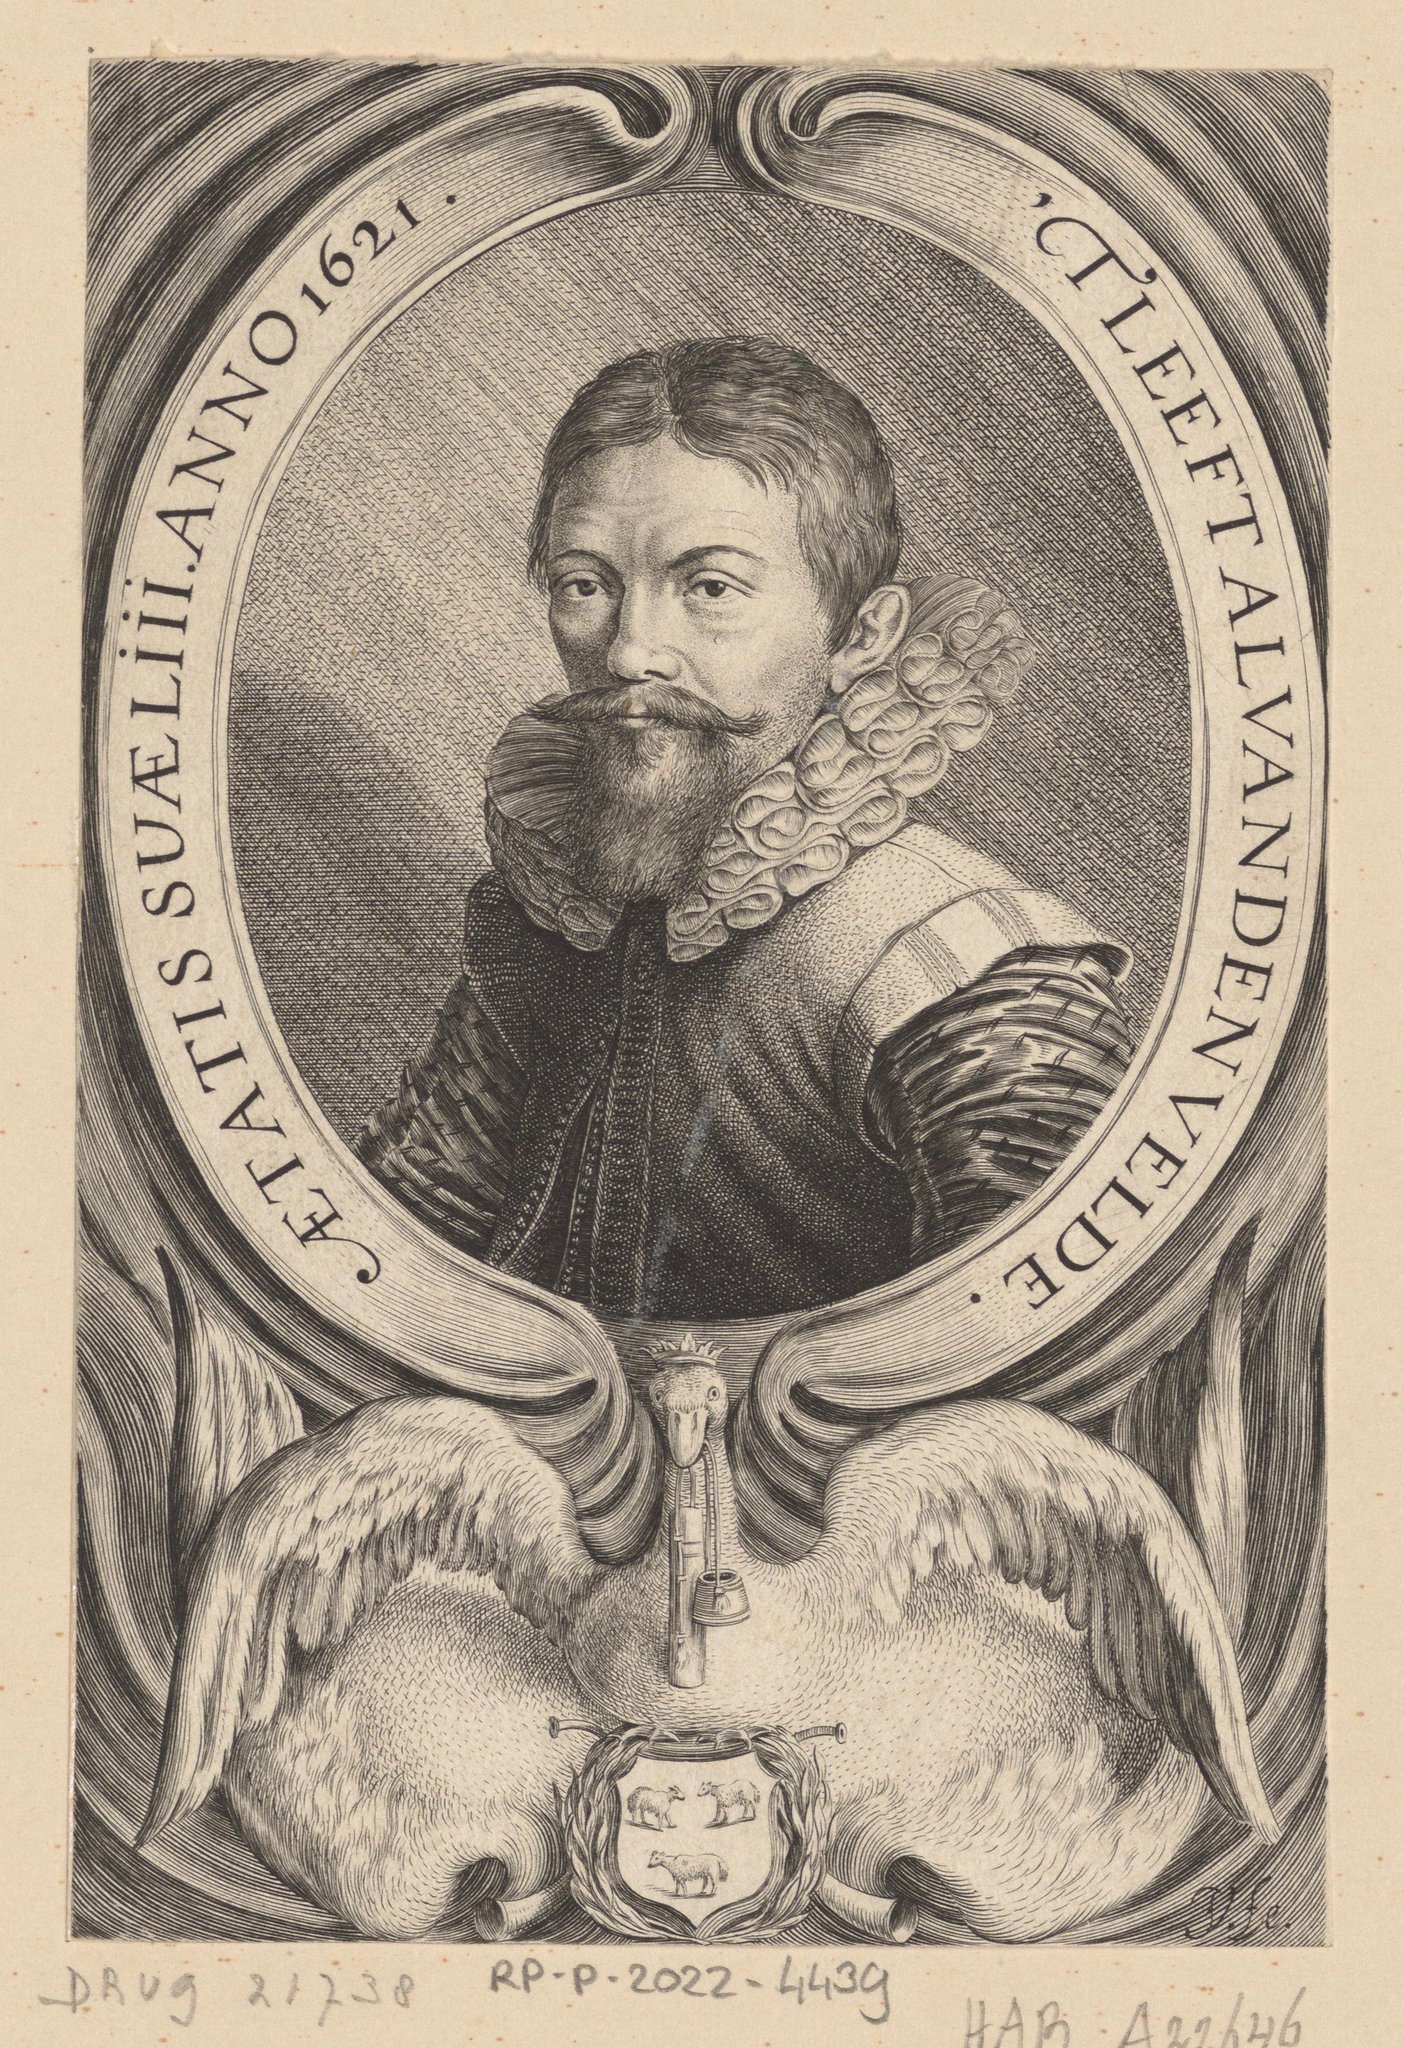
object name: print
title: Portret van Jan van de Velde I op 53-jarige leeftijd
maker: jan van de velde (ii)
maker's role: draughtsman, painter, print maker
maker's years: 1593-1641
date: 1621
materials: paper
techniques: engraving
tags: haarlem, painter, jan van de velde (i), water-birds: swan, historical persons, portrait, self-portrait of painter, armorial bearing, heraldry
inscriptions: collector's mark: Lugt 240, collector's mark: Lugt 698